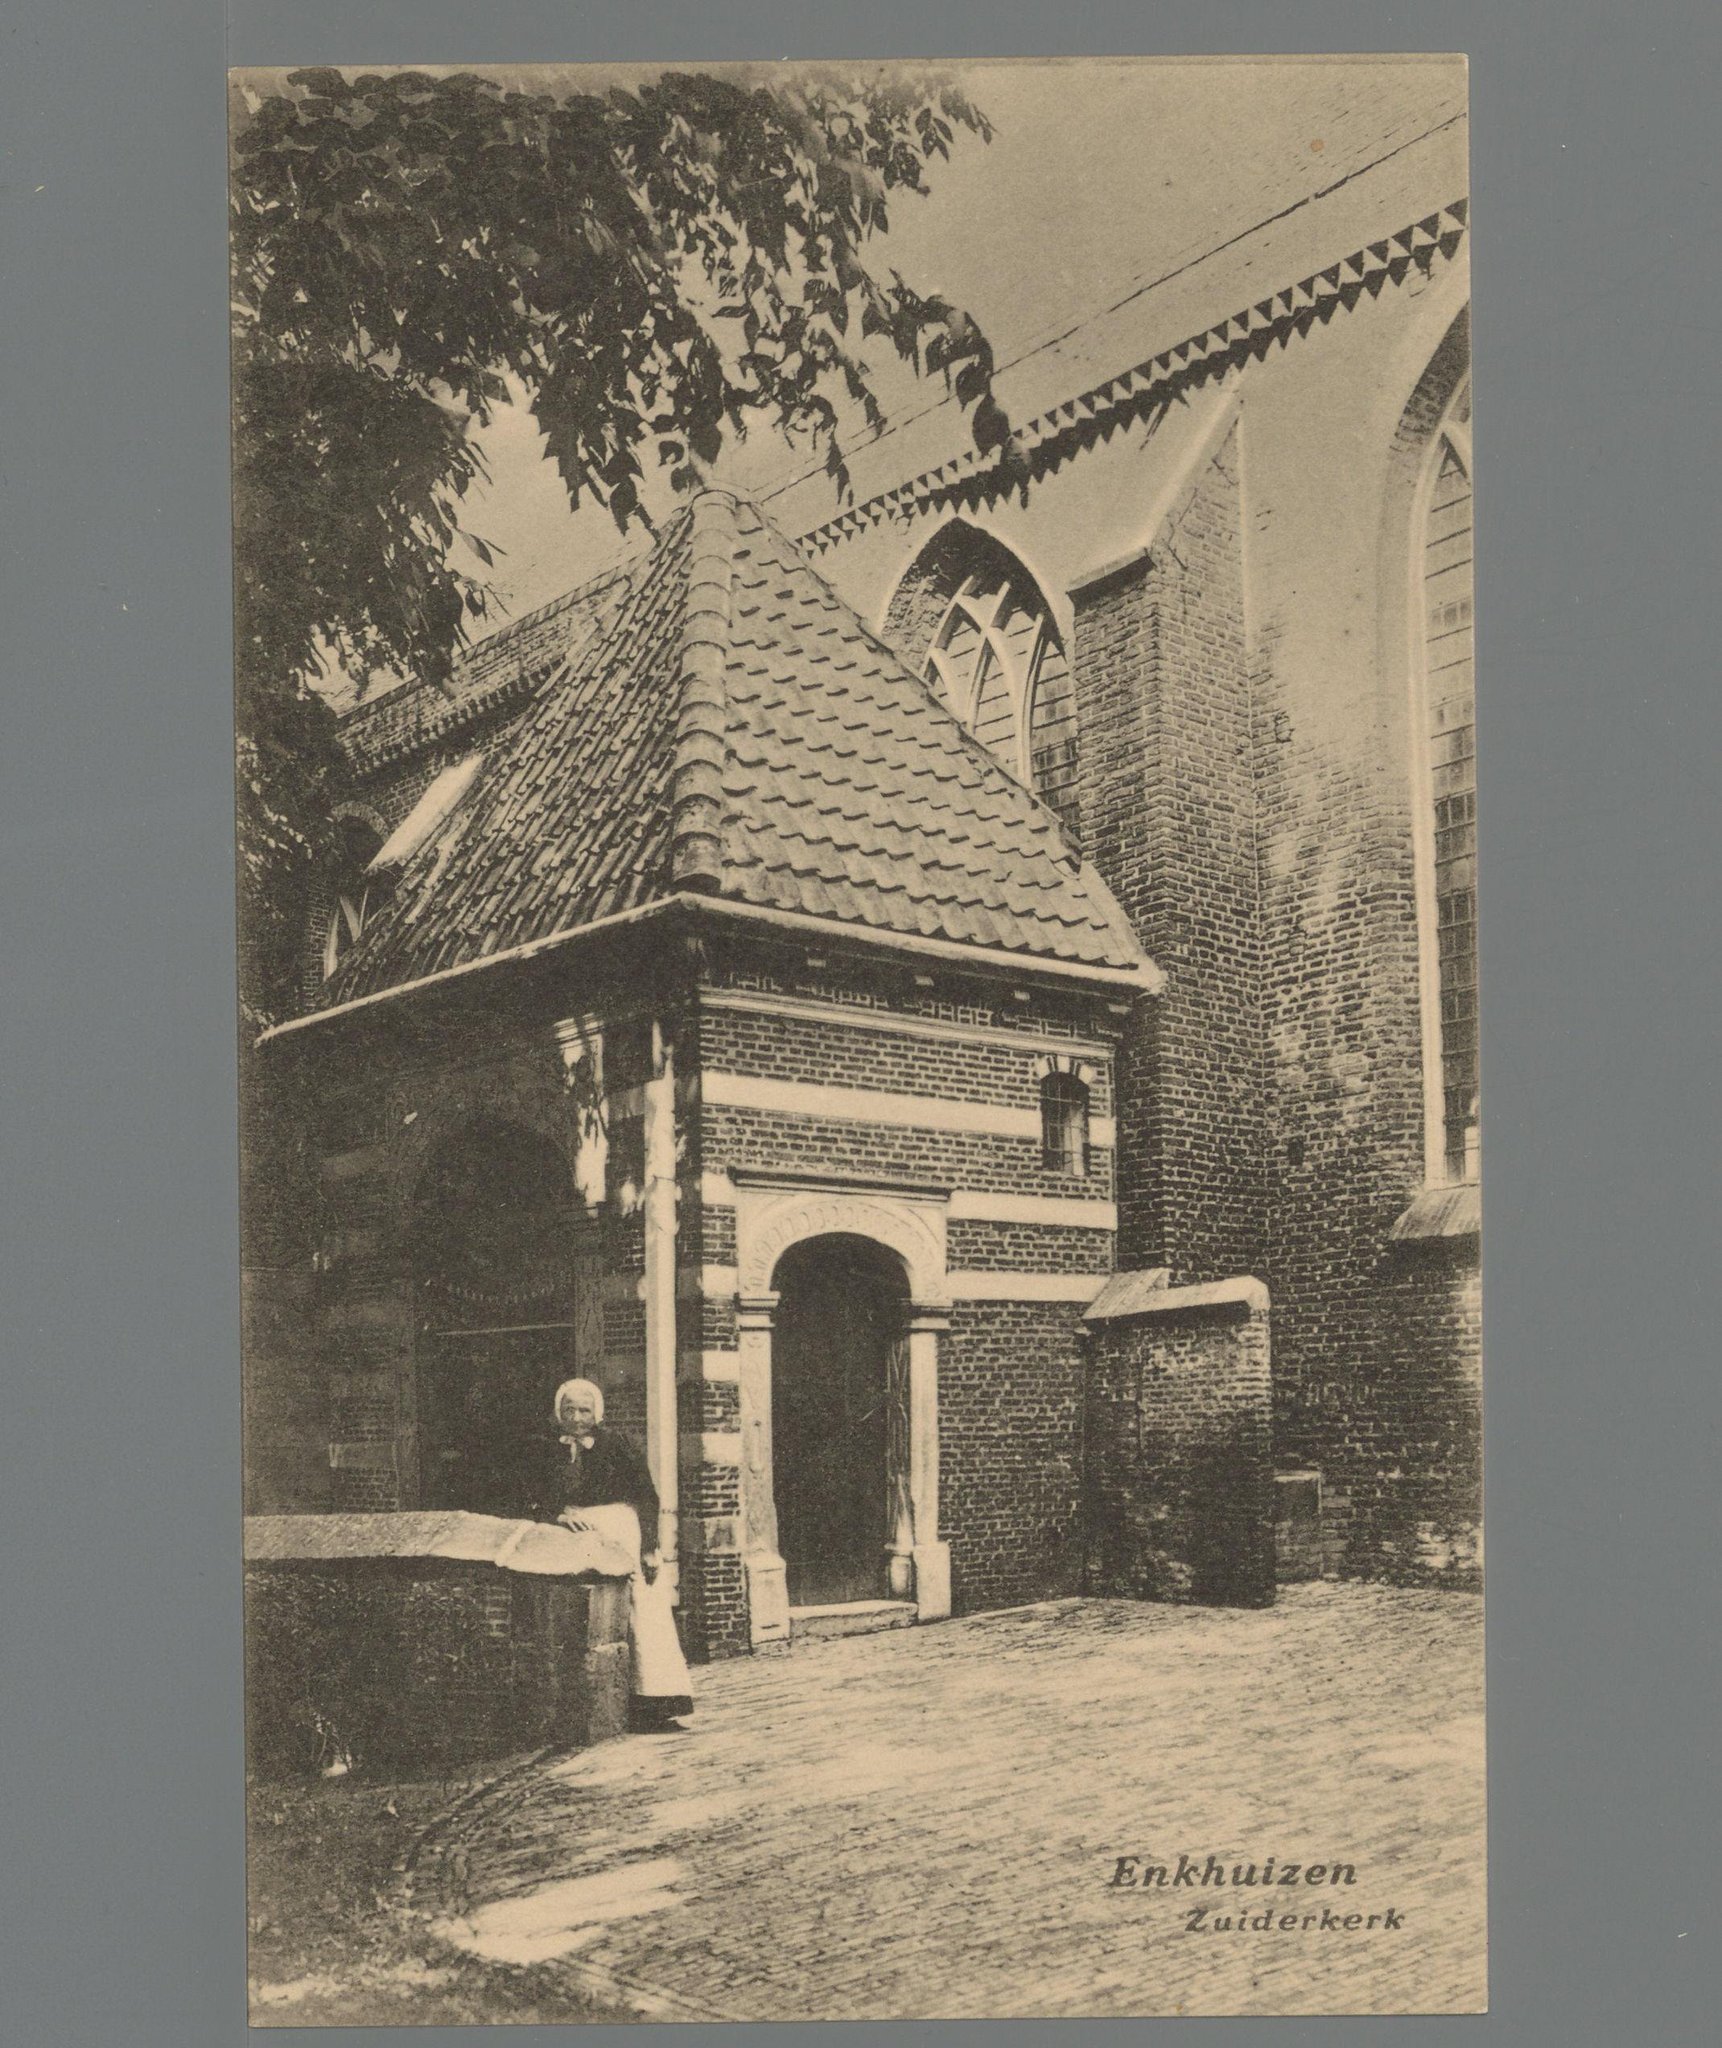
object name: photomechanical print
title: Enkhuizen Zuiderkerk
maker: Anonymous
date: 1913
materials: cardboard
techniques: photograph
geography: leipzig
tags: parts of church exterior and annexes, enkhuizen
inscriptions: date